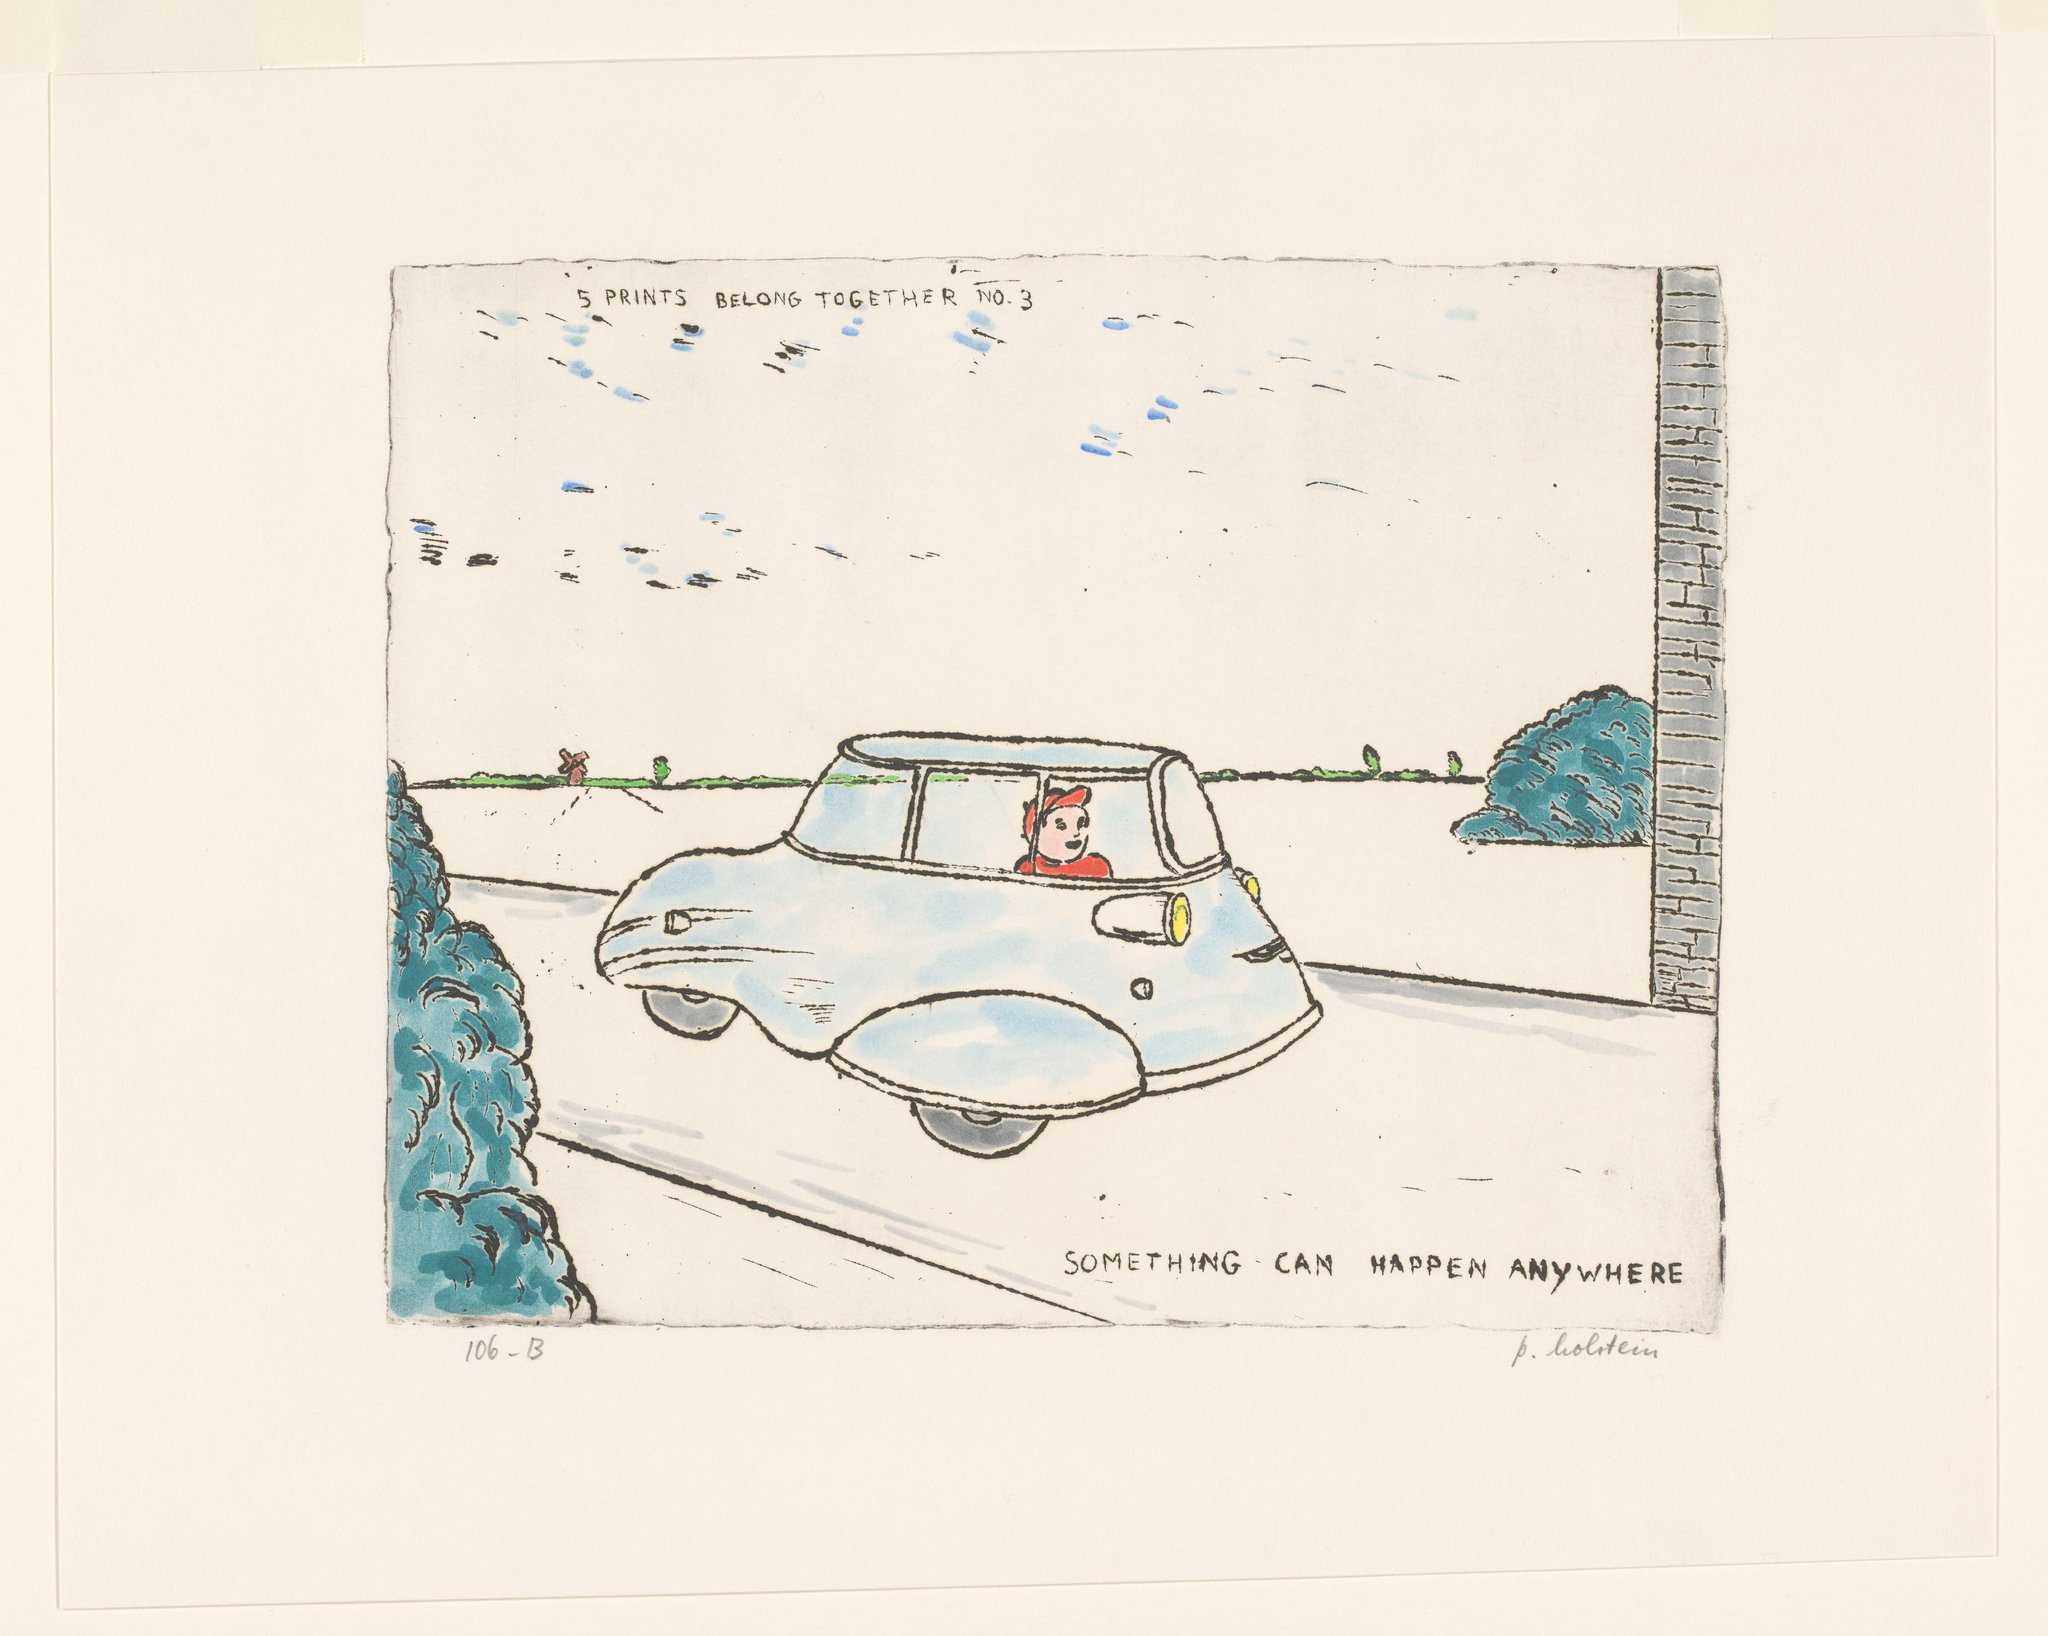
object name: print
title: Five Prints Belong Together no. 3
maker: pieter holstein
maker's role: draughtsman, painter, print maker, sculptor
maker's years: 1934-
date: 1970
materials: paper, watercolor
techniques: brush, etching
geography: amsterdam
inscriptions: inscription: ‘106-B’, title: ‘5 PRINTS BELONG TOGETHER NO. 3’, signature: ‘p. holstein’, title: ‘SOMETHING CAN HAPPEN ANYWHERE’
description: Jongen met pet op, in auto met drie wielen.